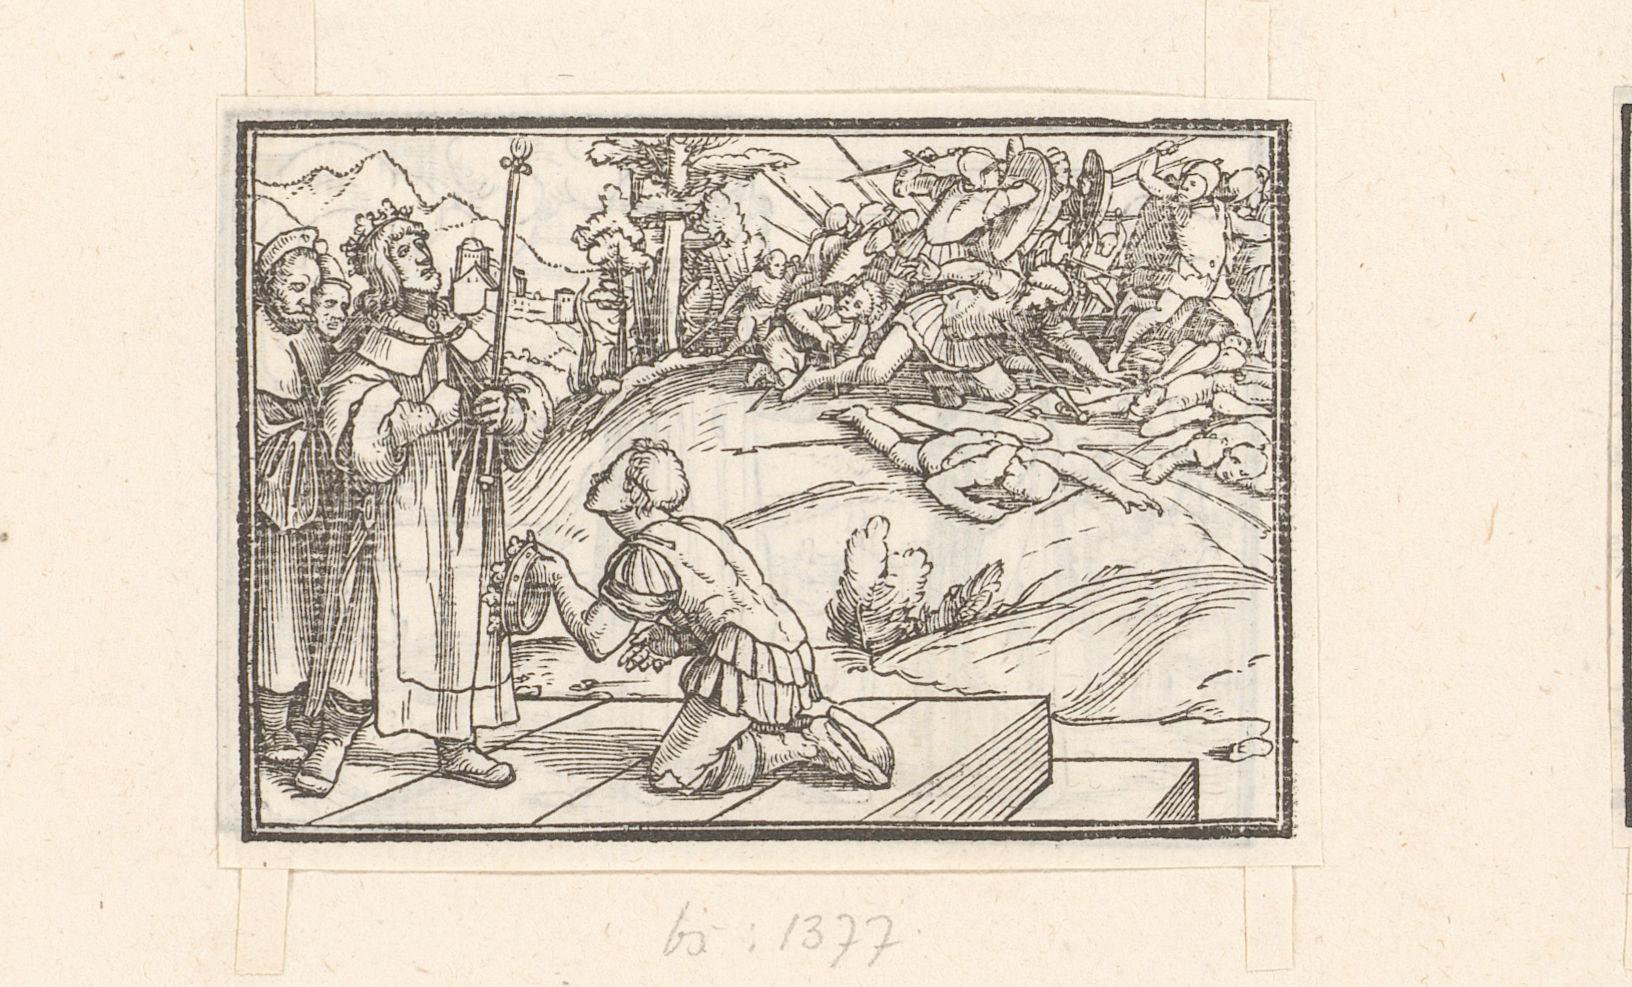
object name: print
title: David hoort van de dood van Saul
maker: veit rudolf specklin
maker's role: print maker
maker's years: -1550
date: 1538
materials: paper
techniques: woodcut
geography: switzerland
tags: a messenger brings the tidings of saul's (and jonathan's) death to david; the messenger falls prostrate to the ground before david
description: Boekillustratie voor het eerst gebruikt in: Biblia Utriusque Testamenti iuxta Vulgatam Translationem, Lyon, M. en G. Trechsel (voor Hugo à Porta) 1538. Later in verschillende uitgaven opnieuw gebruikt. Deze prent vermoedelijk gebruikt in één van de uitgaven uitgegeven en/of gedrukt door Jean Frellon, Lyon.